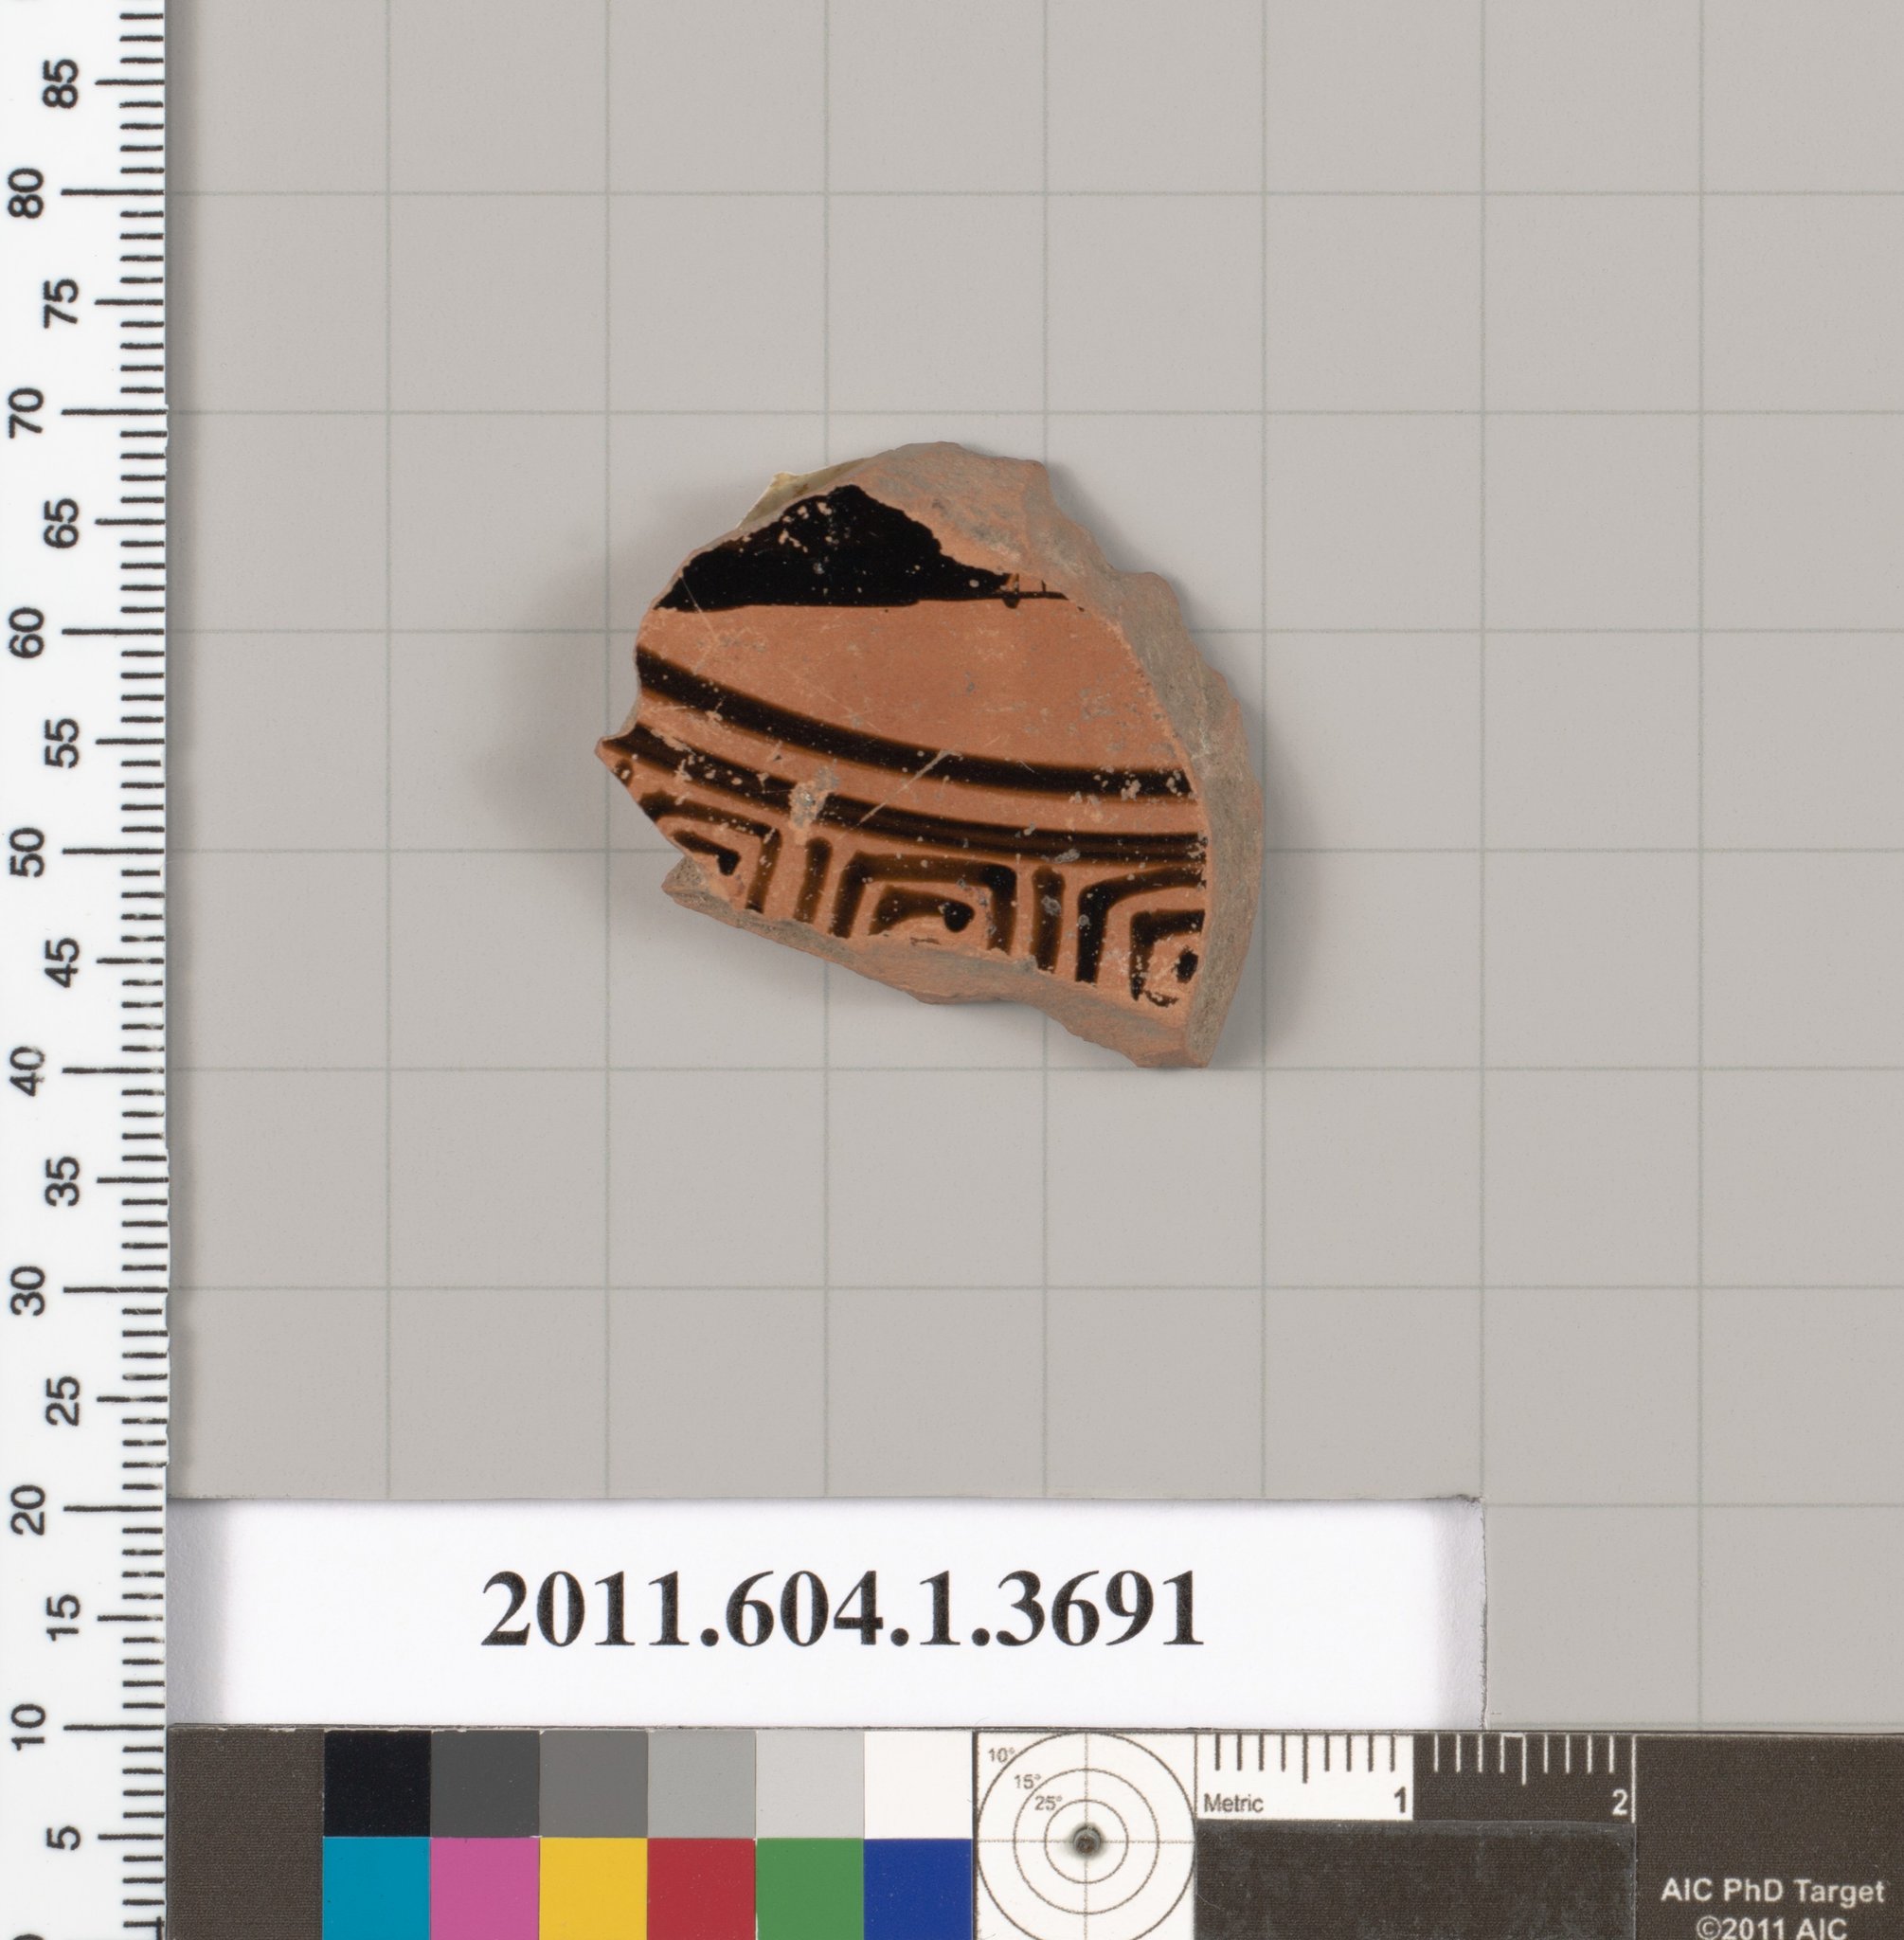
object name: kylix fragment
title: Terracotta fragment of a kylix (drinking cup)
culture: greek, attic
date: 500-470 BCE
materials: terracotta